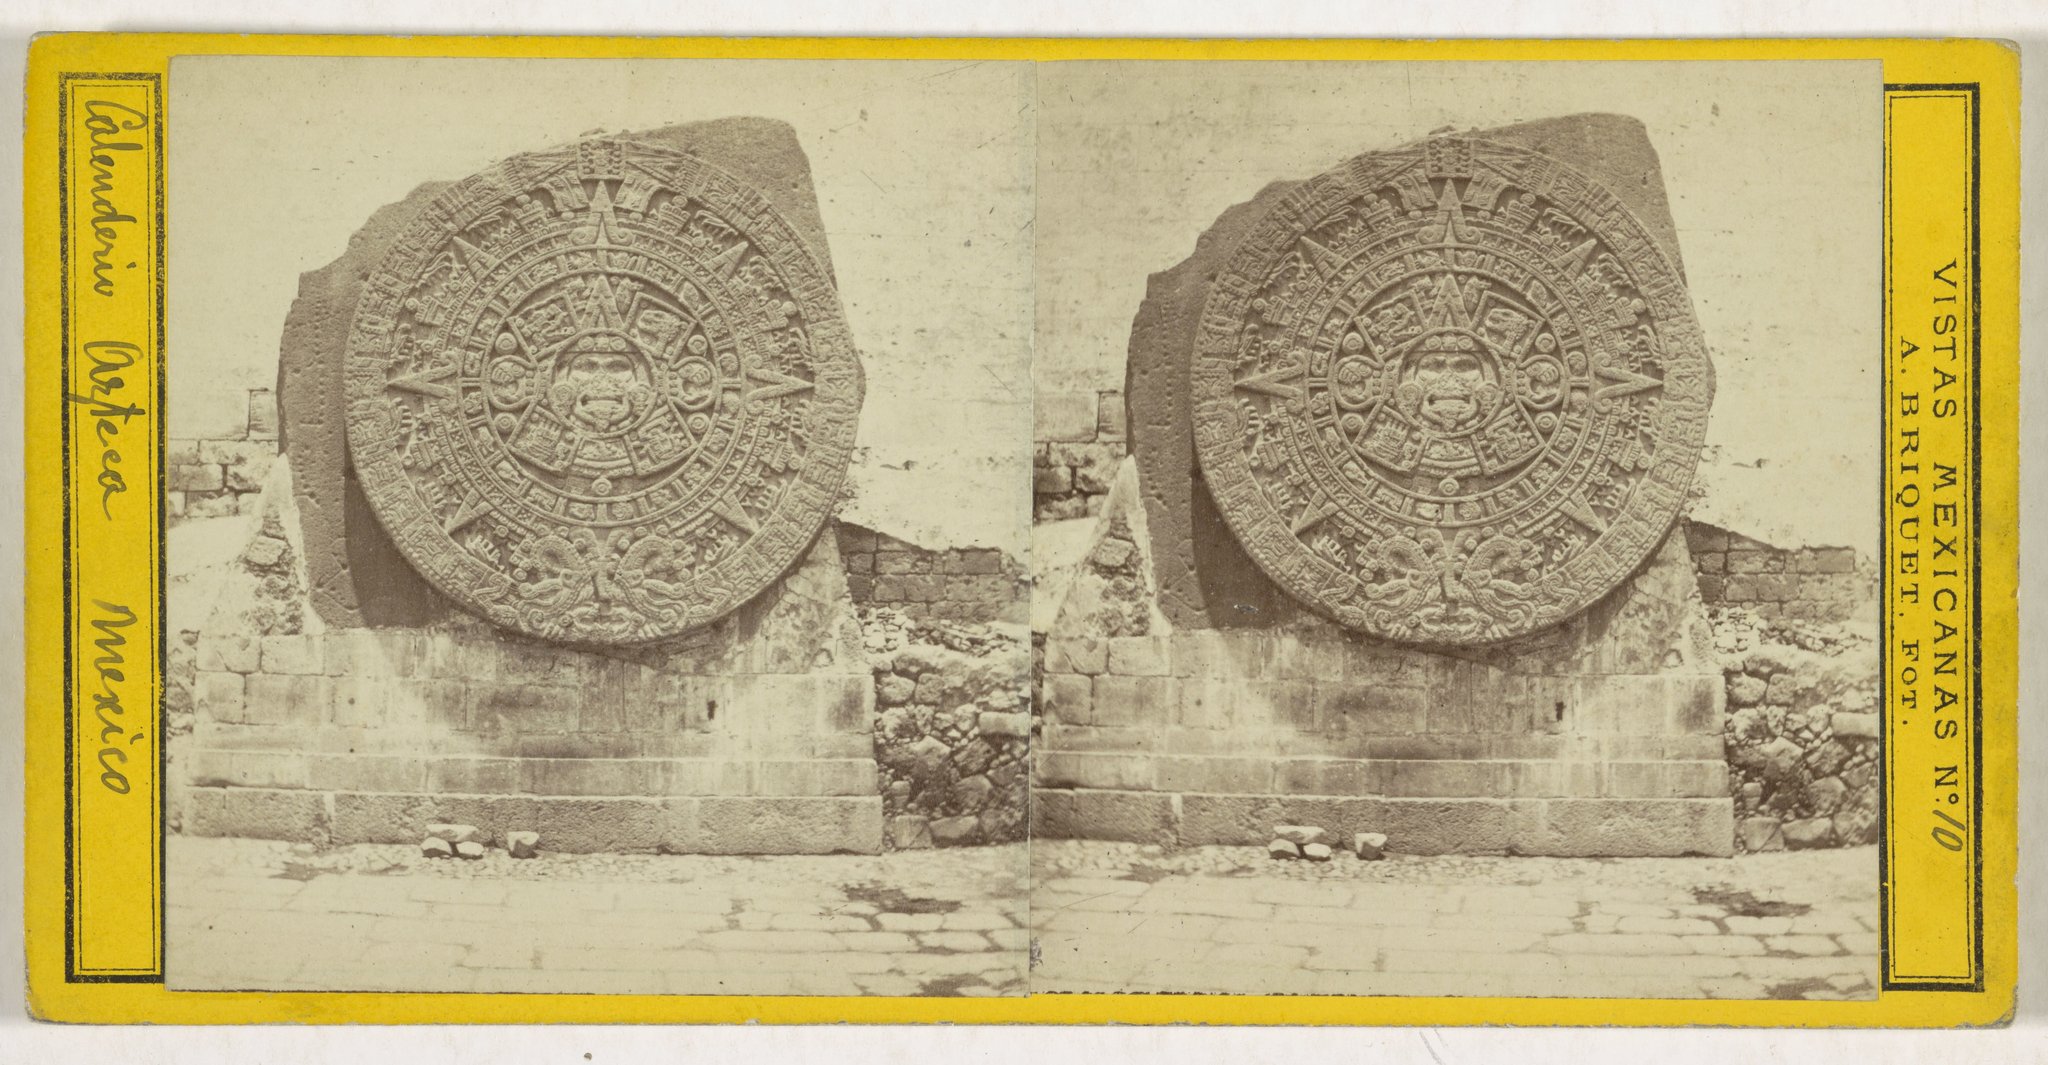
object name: stereograph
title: Piedra del Sol in Mexico-Stad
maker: abel briquet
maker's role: fotograaf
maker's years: 1833-1926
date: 1861-1870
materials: cardboard, paper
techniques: albumen print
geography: mexico city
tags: sculpture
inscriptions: number: ‘No. 10’